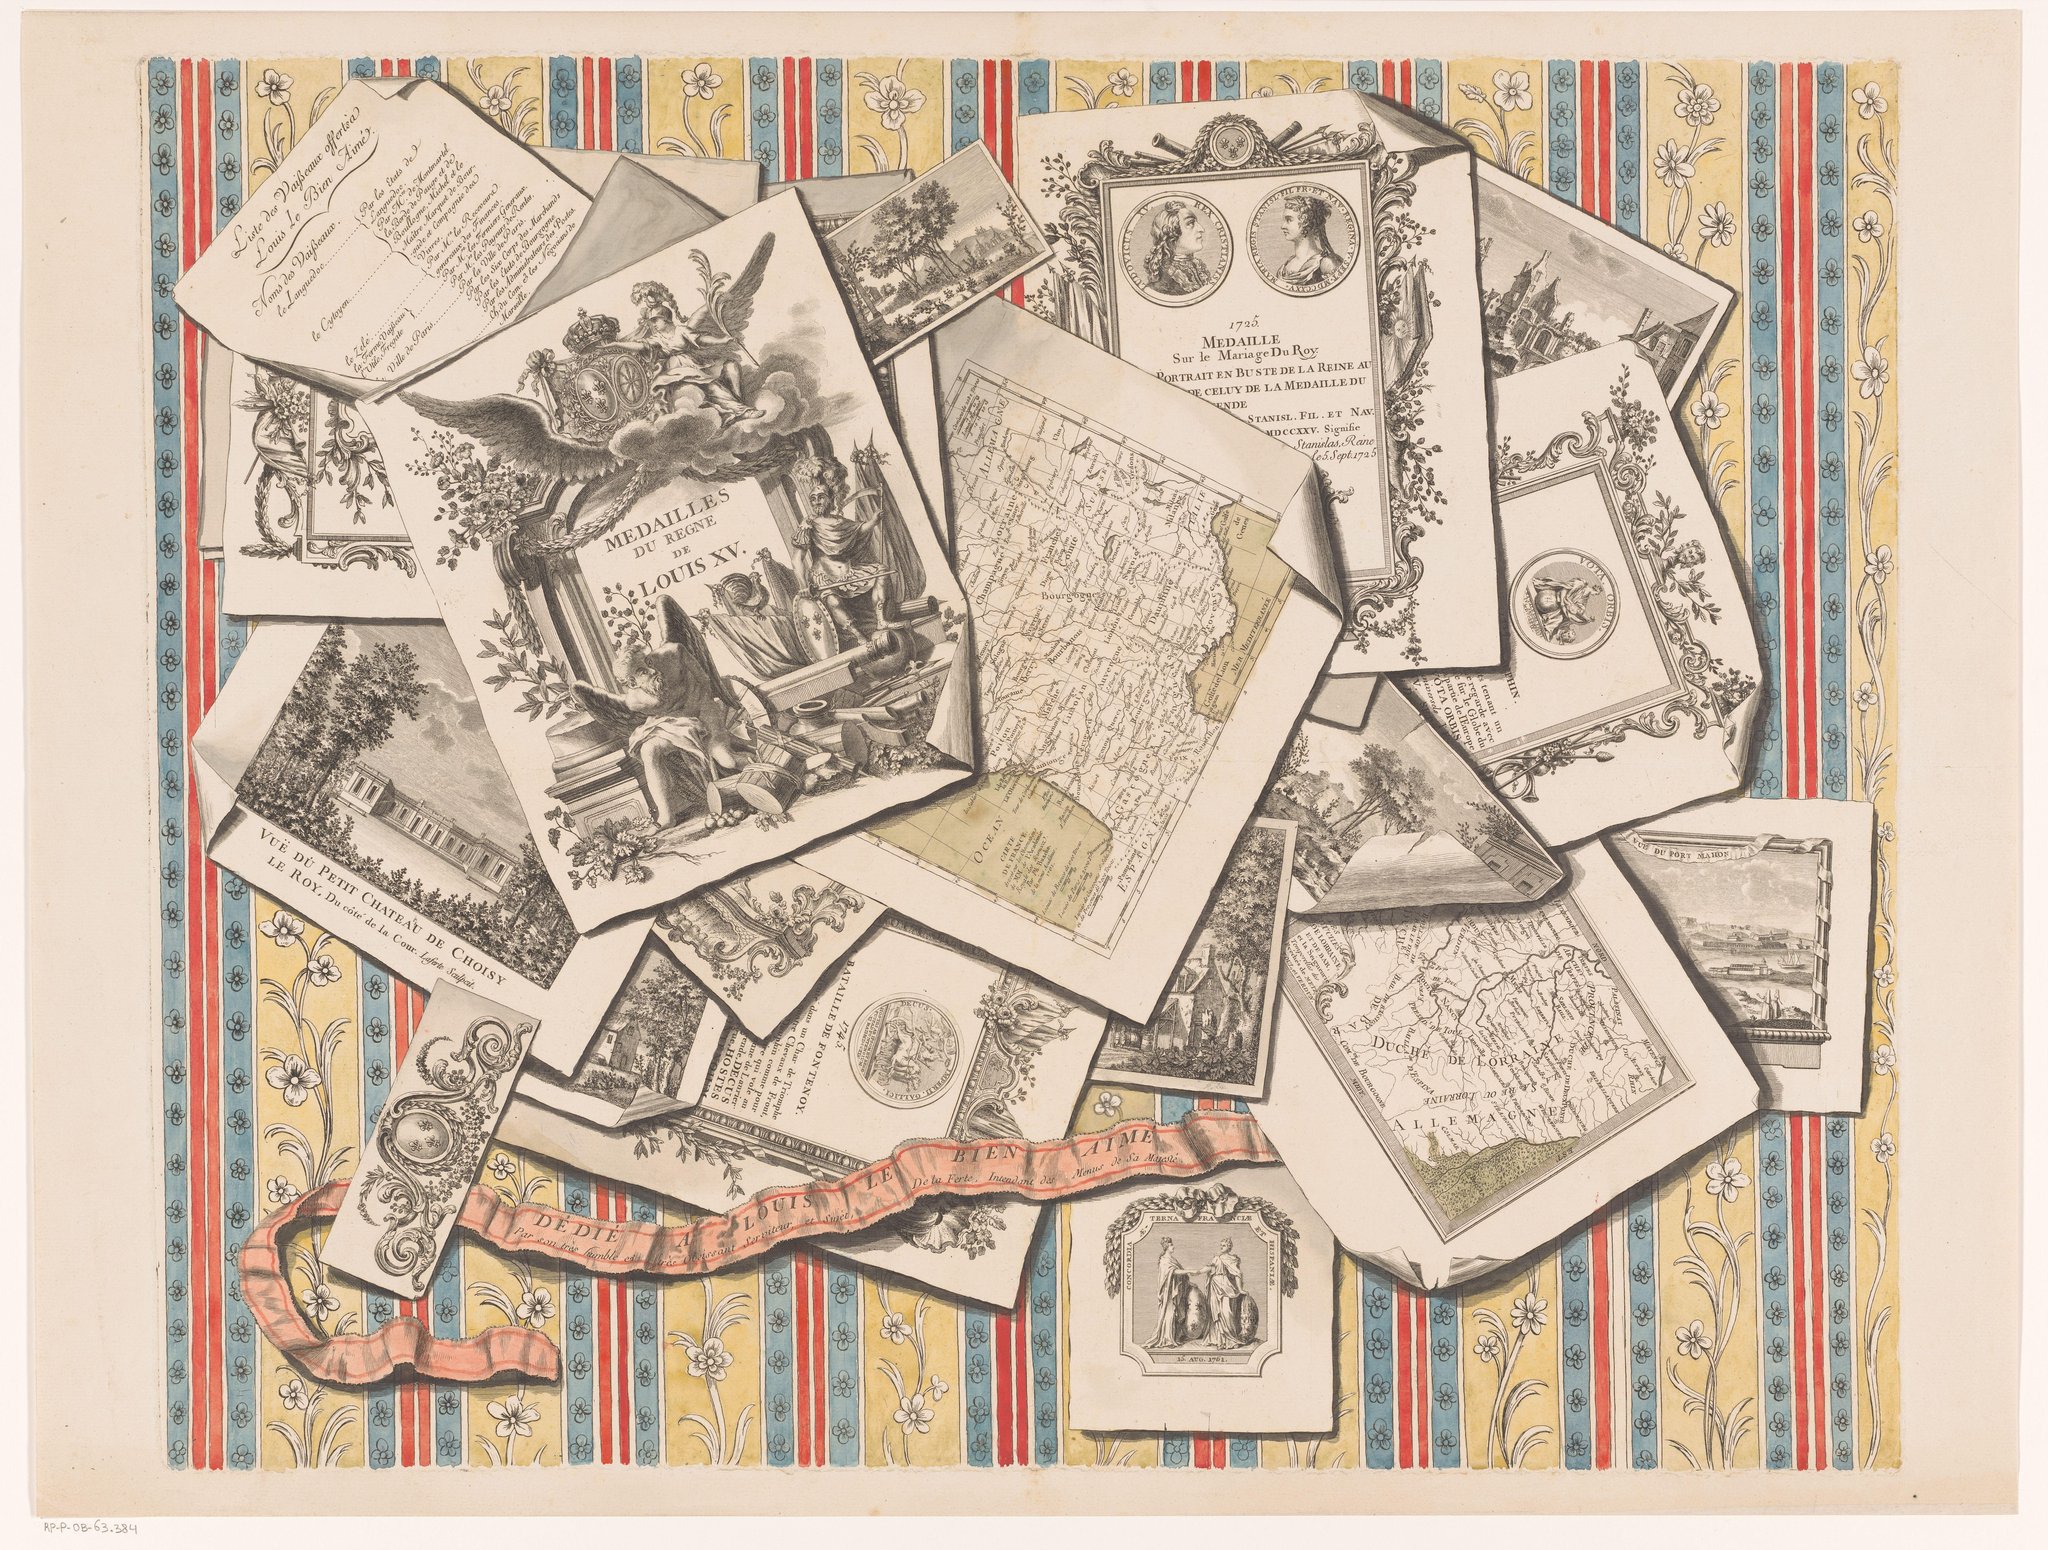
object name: print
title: Trompe l'oeil van prenten en landkaarten betrekking hebbend op Lodewijk XV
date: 1737-1774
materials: paper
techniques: etching, hand coloring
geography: france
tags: louis xv of france, wall-paper, 'trompe l'oeil', print, e.g.: engraving, etching, lithograph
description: Ornamentprenten, landkaarten en gezichten op kastelen hangen tegen een wand van behangselpapier met verticale banen en bloemmotieven.